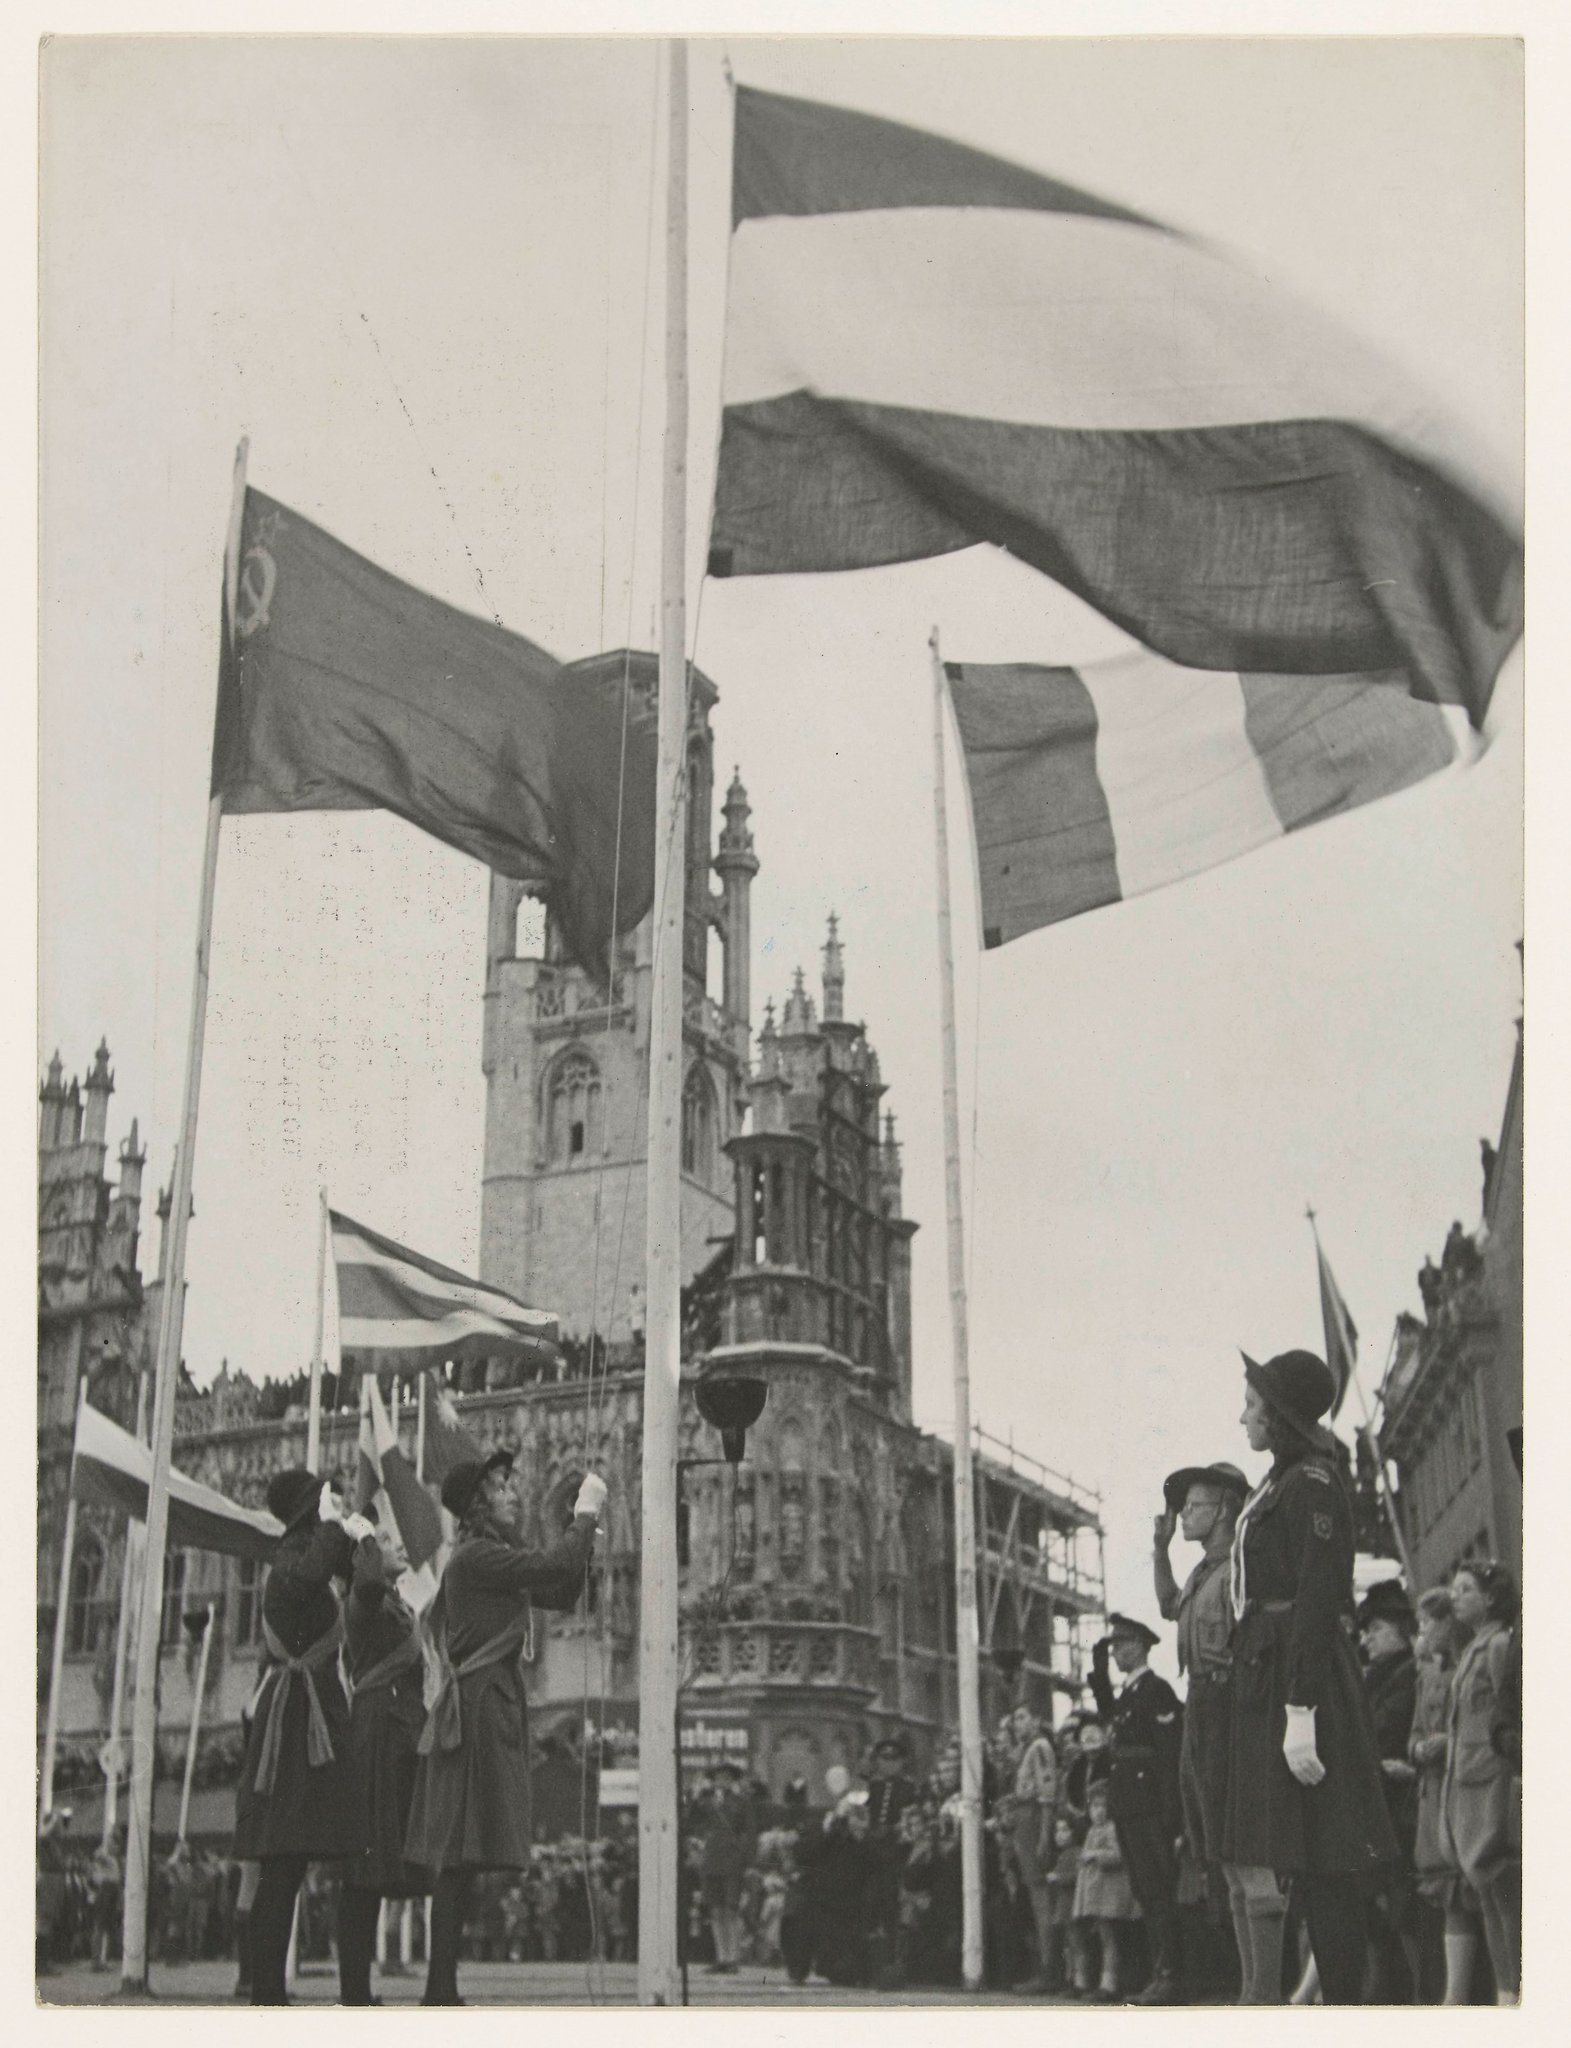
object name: documentary photograph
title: Walcheren's grote dag!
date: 1947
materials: photographic support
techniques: photography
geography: middelburg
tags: publisher, middelburg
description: De eerste grootschalige herdenking op Walcheren, na het onder water zetten door de geallieerden, vond plaats op 4 november 1947: de Boomplantdag. De herdenkingsdag werd georganiseerd door de Stichting Nieuw Walcheren en werd bijgewoond door prinses Juliana, prins Bernhard en de Britse premier Attlee. Padvinders hijsen vlaggen, waaronder de vlaggen van de Sovjet-Unie en Nederland, voor de internationale vlaggenparade op de Grote markt ten overstaan van een groot publiek voor het stadhuis. Het stadhuis van Middelburg werd in 1940 zwaar gebombardeerd en wordt op deze foto, getuige de steigers, gerenoveerd.